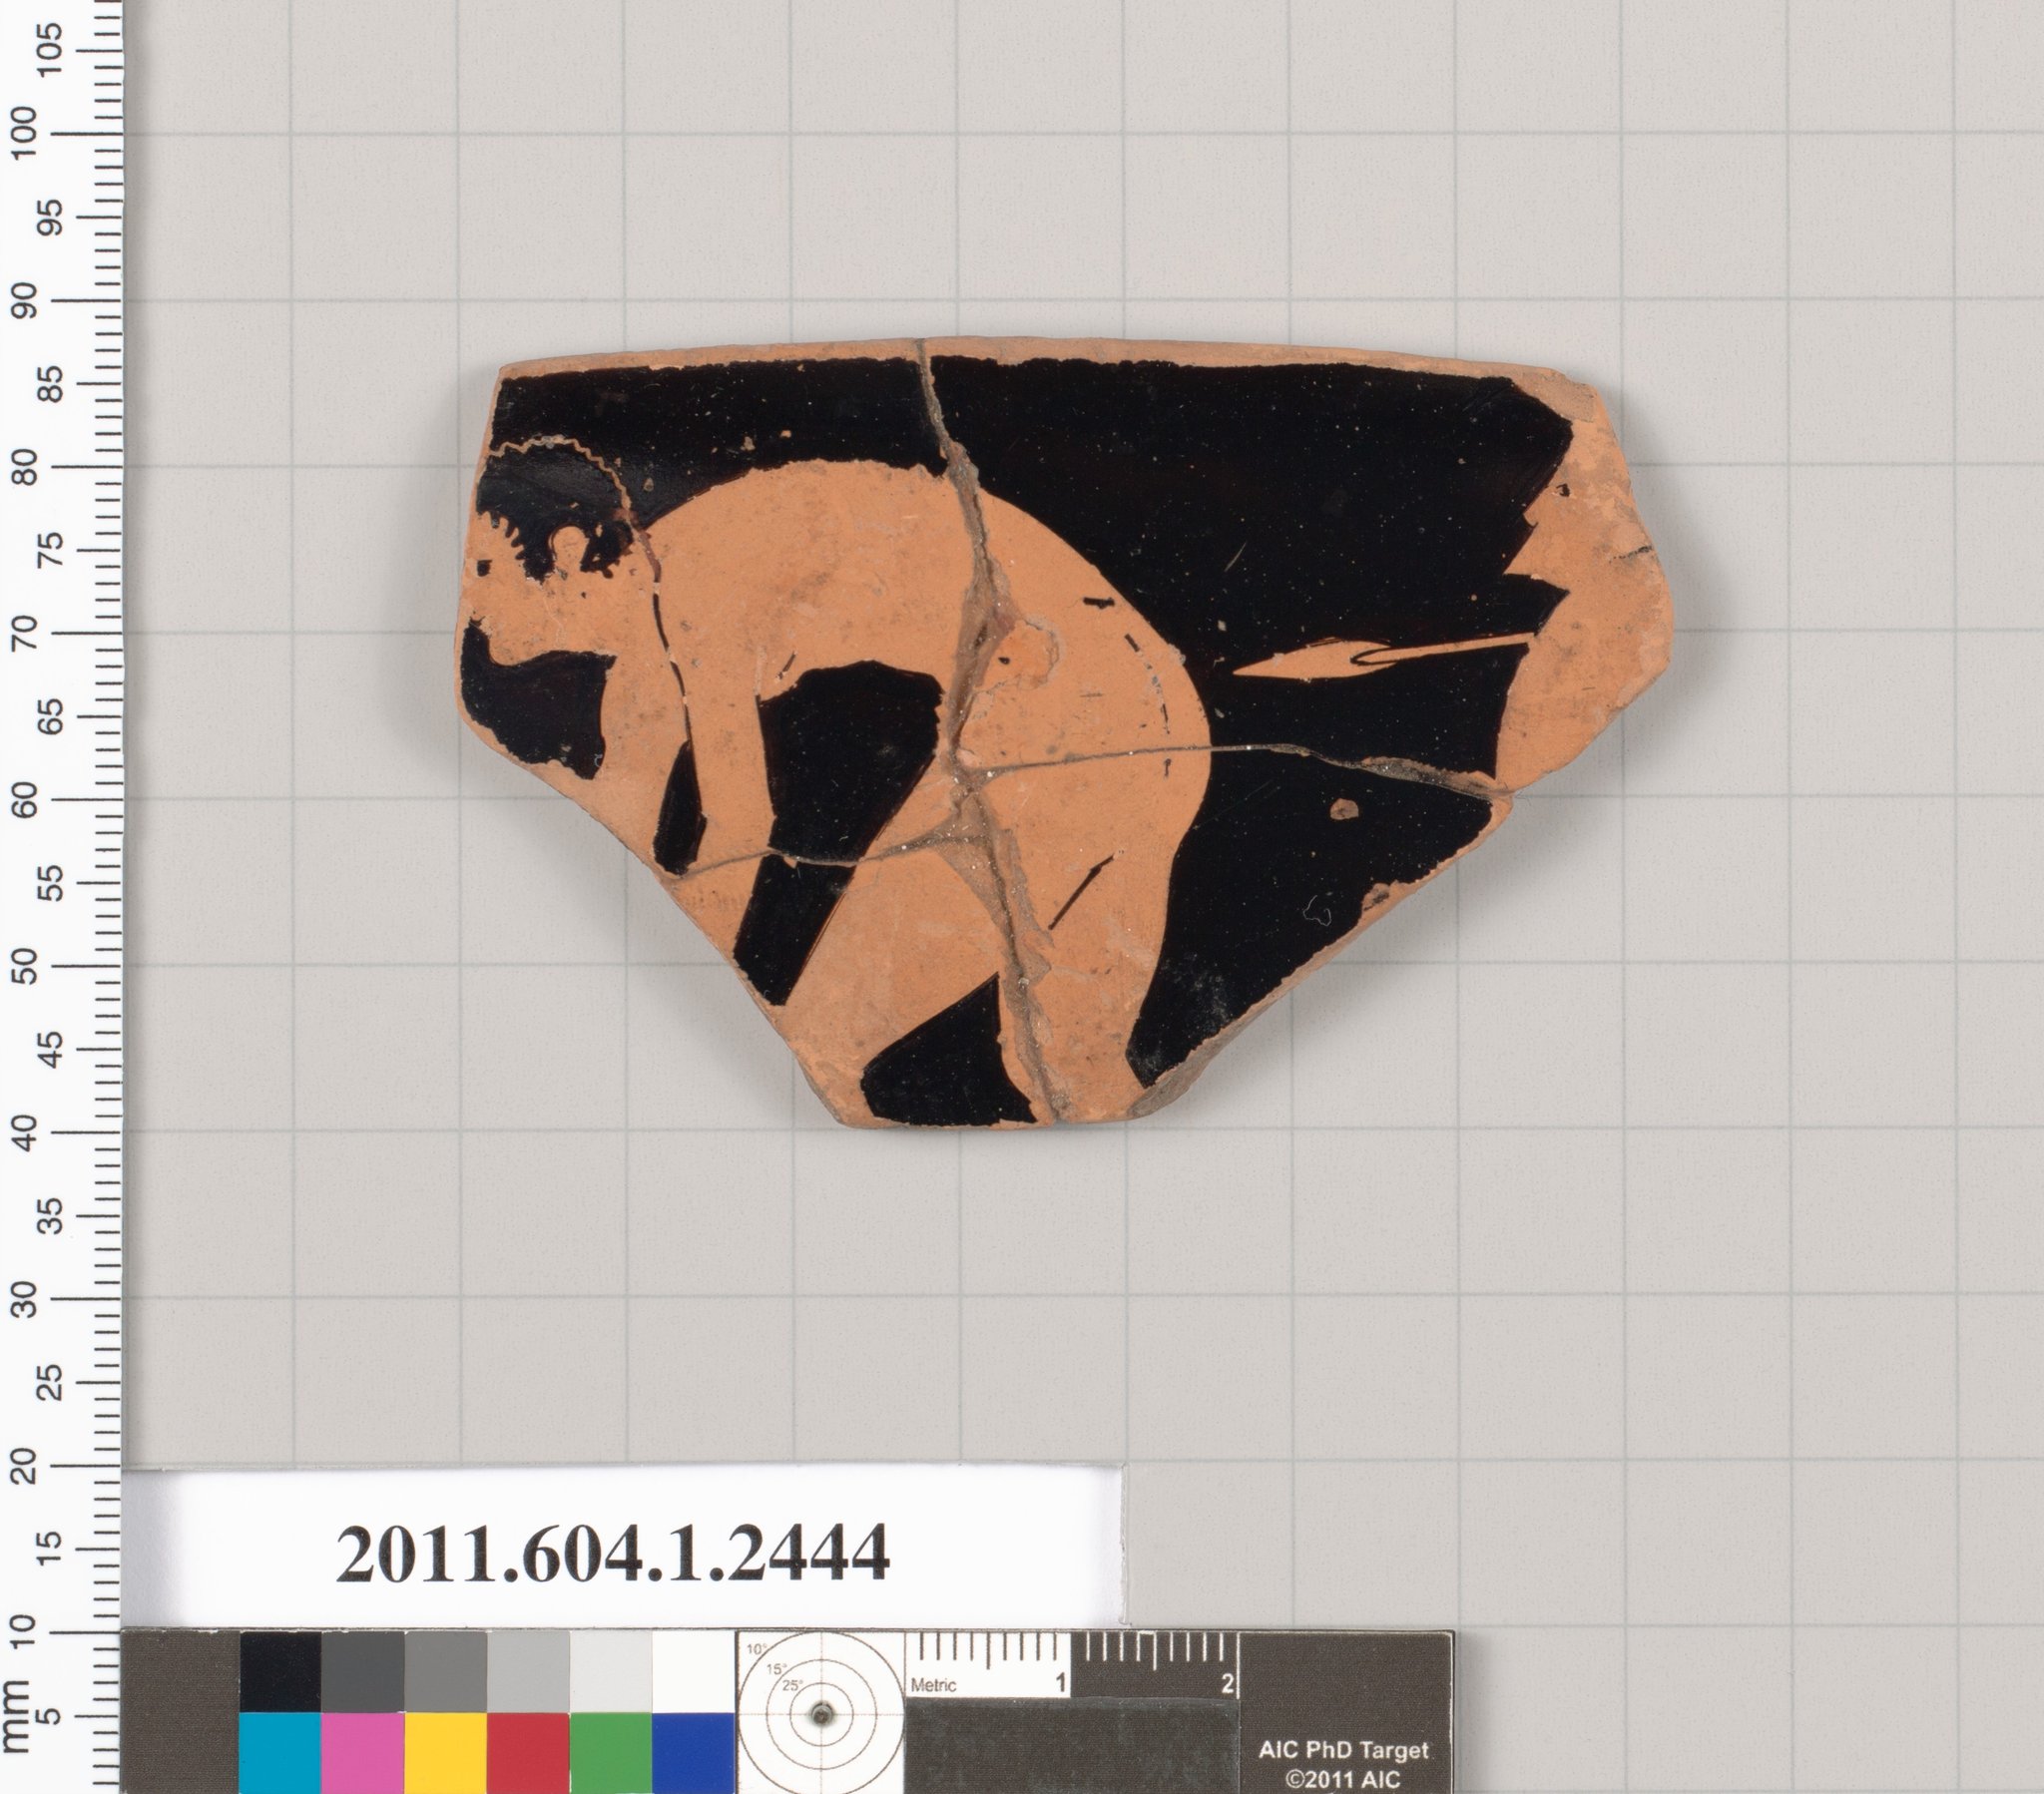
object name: kylix fragment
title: Terracotta rim fragment of a kylix (drinking cup)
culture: greek, attic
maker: ambrosios painter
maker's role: artist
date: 520-500 BCE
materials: terracotta